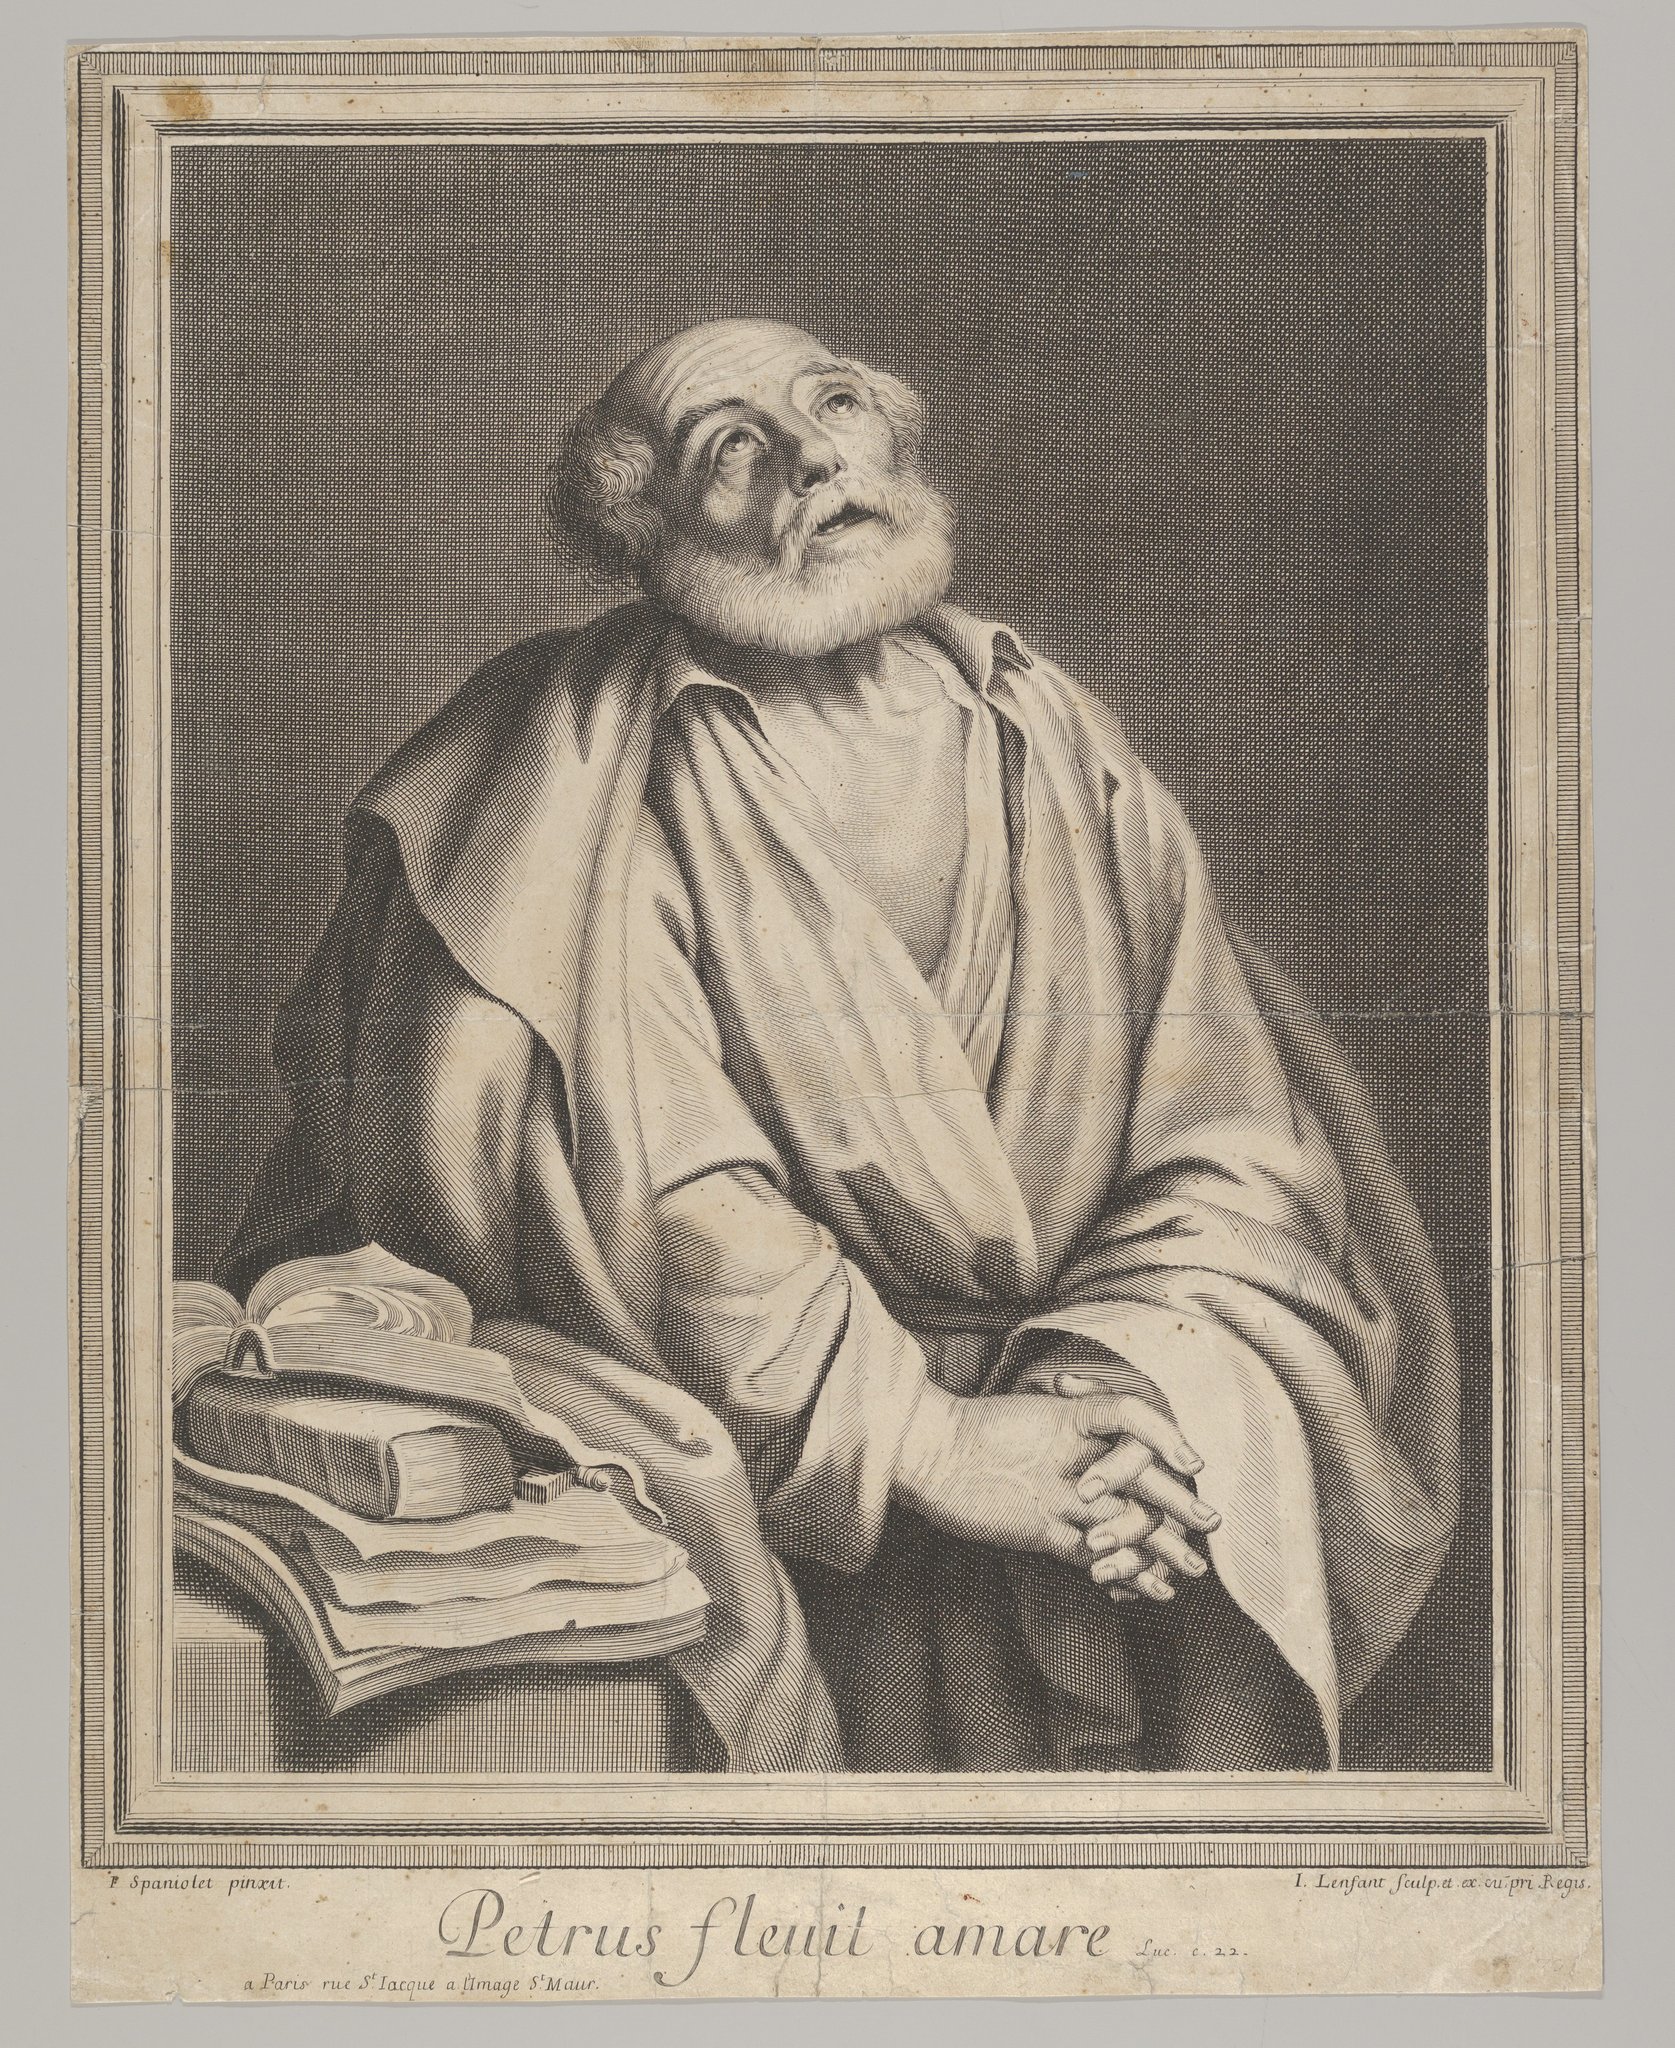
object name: print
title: The Penitence of Saint Peter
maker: jean lenfant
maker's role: artist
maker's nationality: french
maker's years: 1615-1674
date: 1640-1674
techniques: engraving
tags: portraits,saint peter